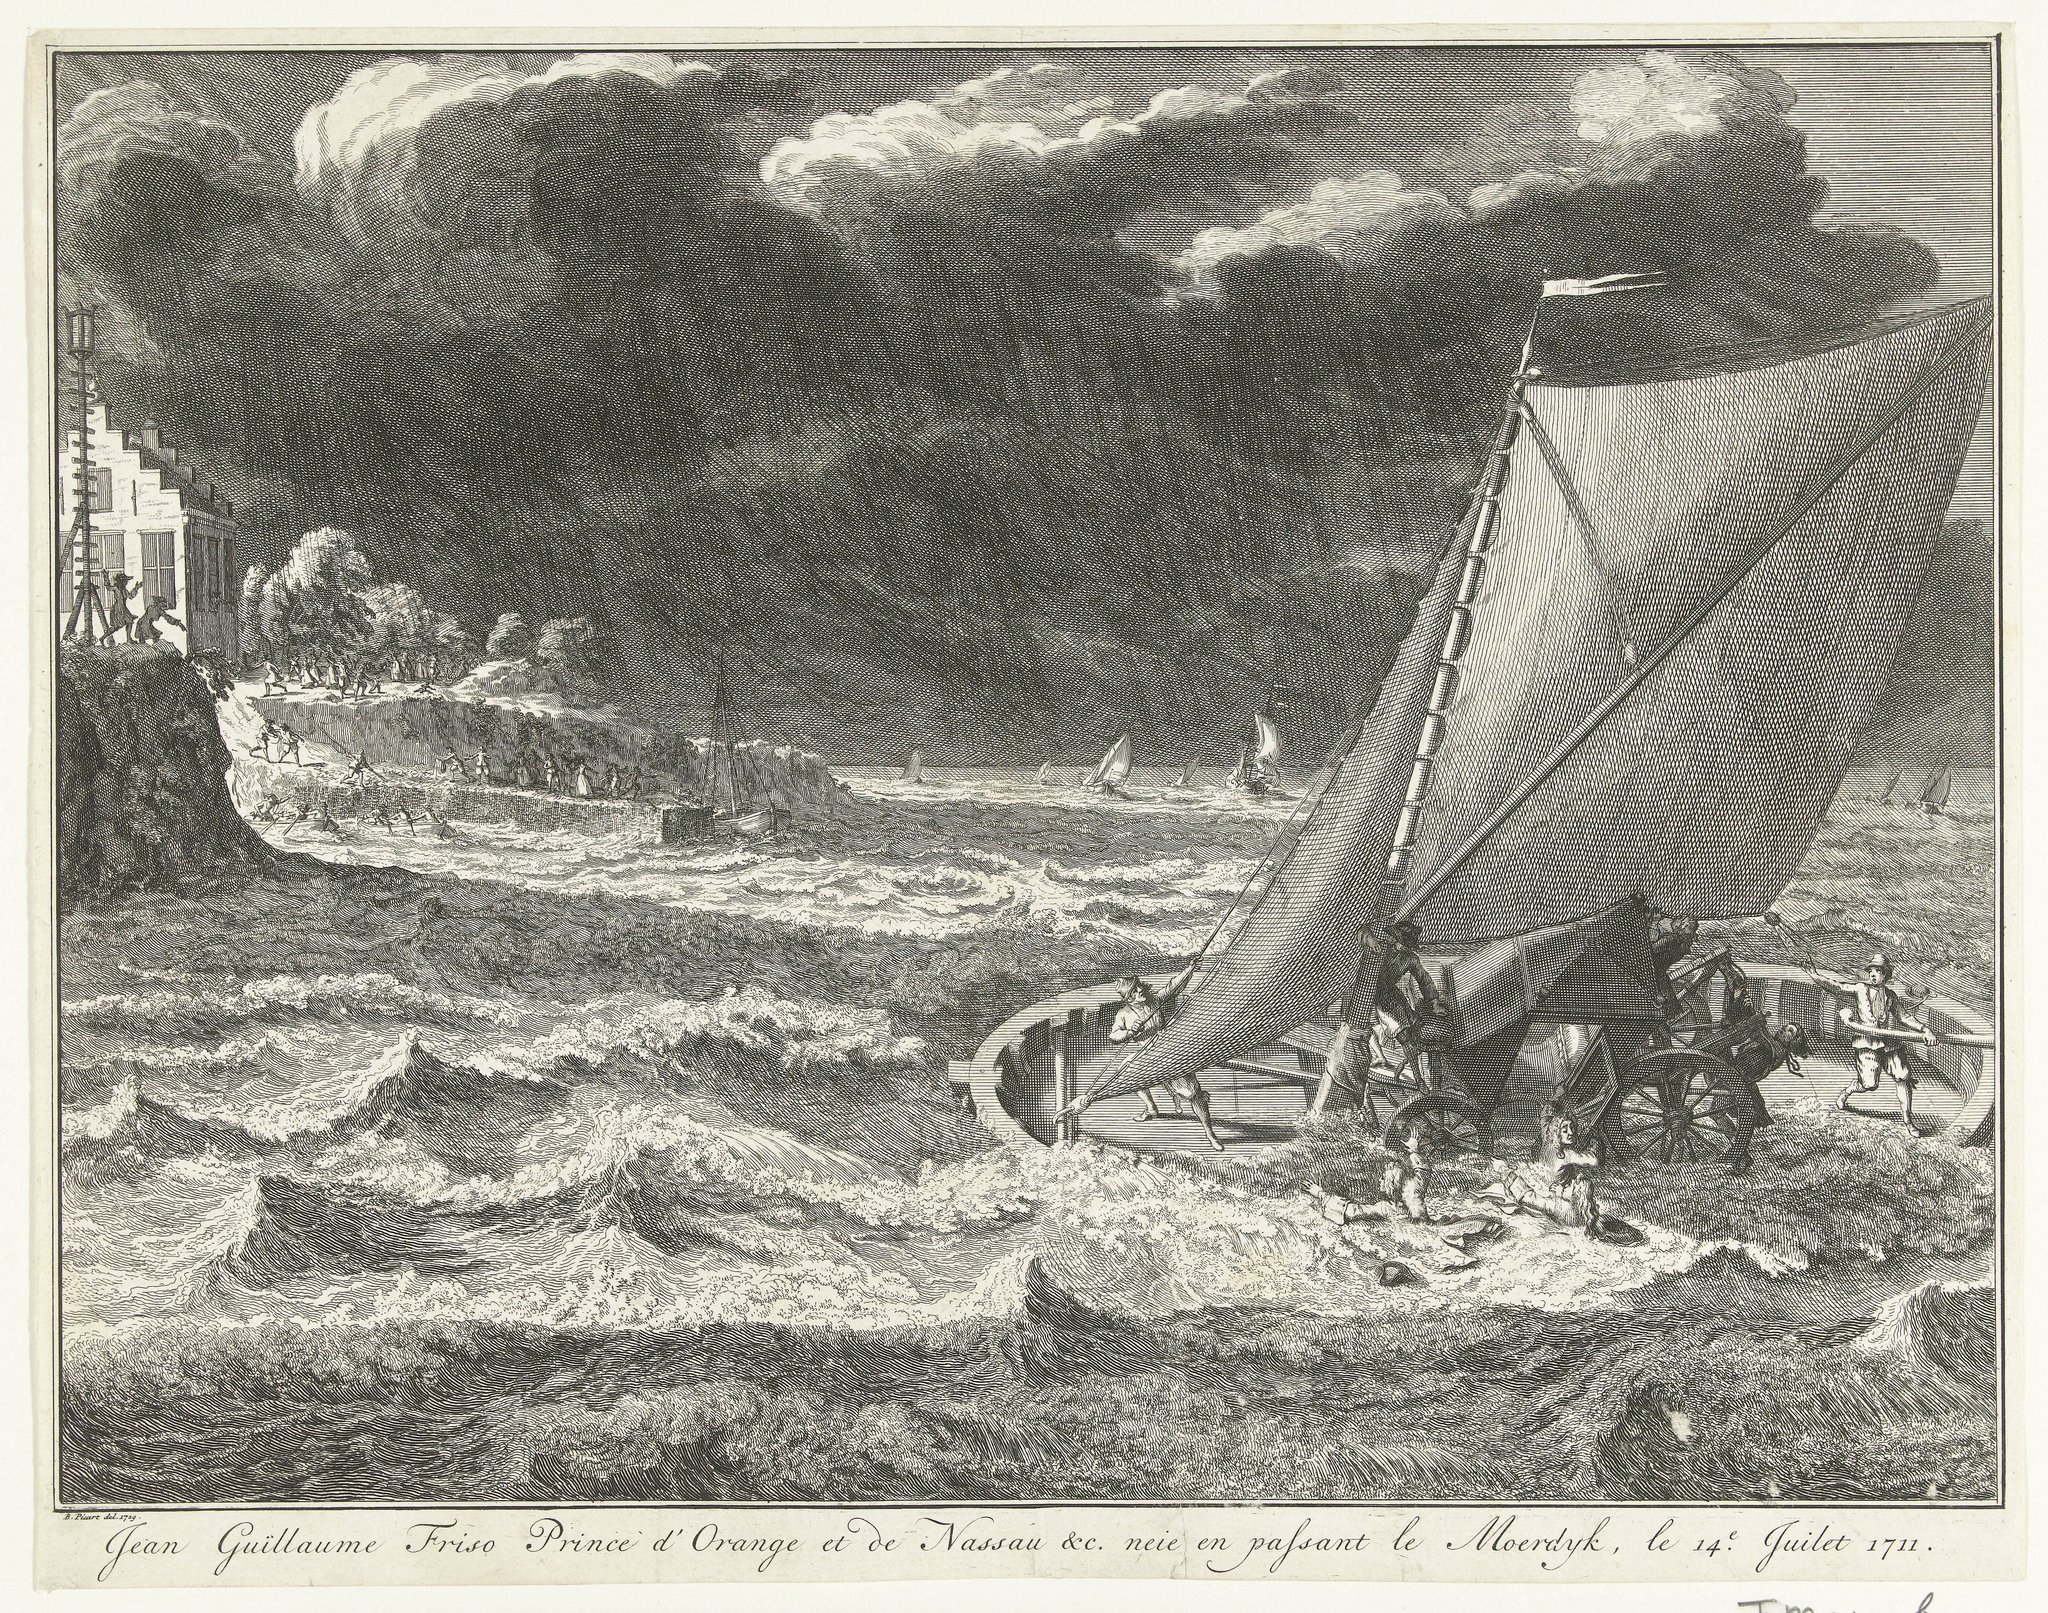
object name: print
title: Verdrinkingsdood van prins Johan Willem Friso, 1711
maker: bernard picart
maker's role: draughtsman, print maker, publisher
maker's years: 1673-1733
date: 1729-1730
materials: paper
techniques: etching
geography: northern netherlands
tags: johan willem friso (prins van oranje-nassau), death by drowning (non-violent)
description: Gebruikt als illustratie in: J. le Clerc, Geschiedenissen der Vereenigde Nederlanden, sedert den aanvang van die Republyk tot op den Vrede van Utrecht in 't jaar 1713 en het Tractaat van Barriere in 't jaar 1715 gesloten, Z. Chatelain, Amsterdam 1730, 3 delen.